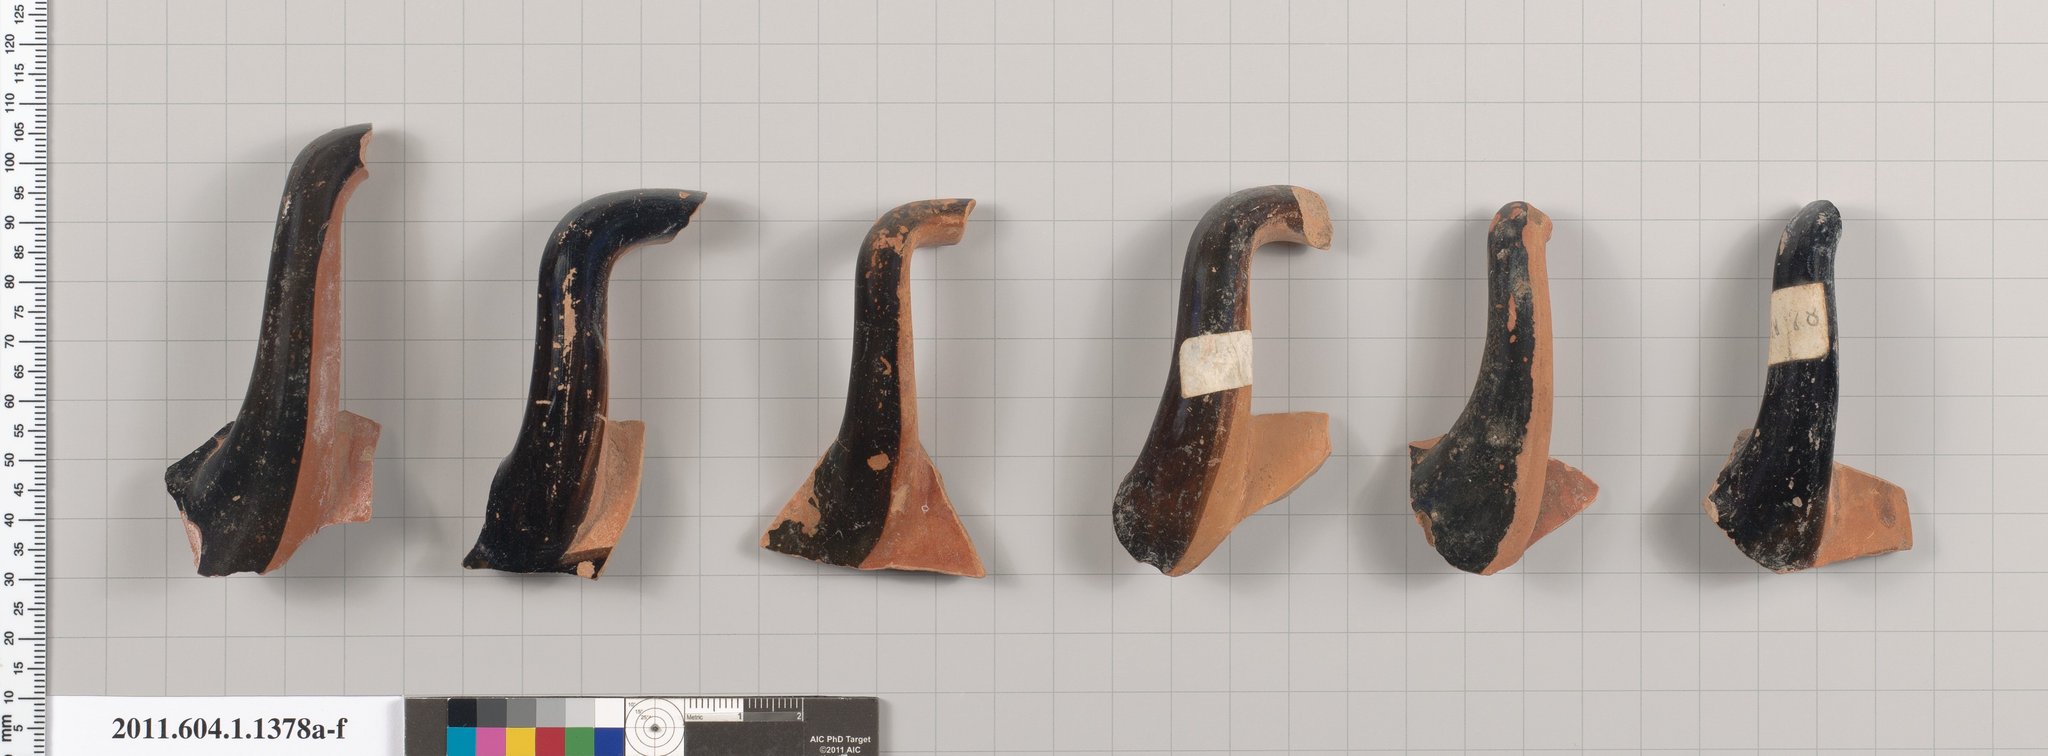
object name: kylix fragment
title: Terracotta fragments of kylikes (drinking cups)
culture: greek, attic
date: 500-401 BCE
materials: terracotta